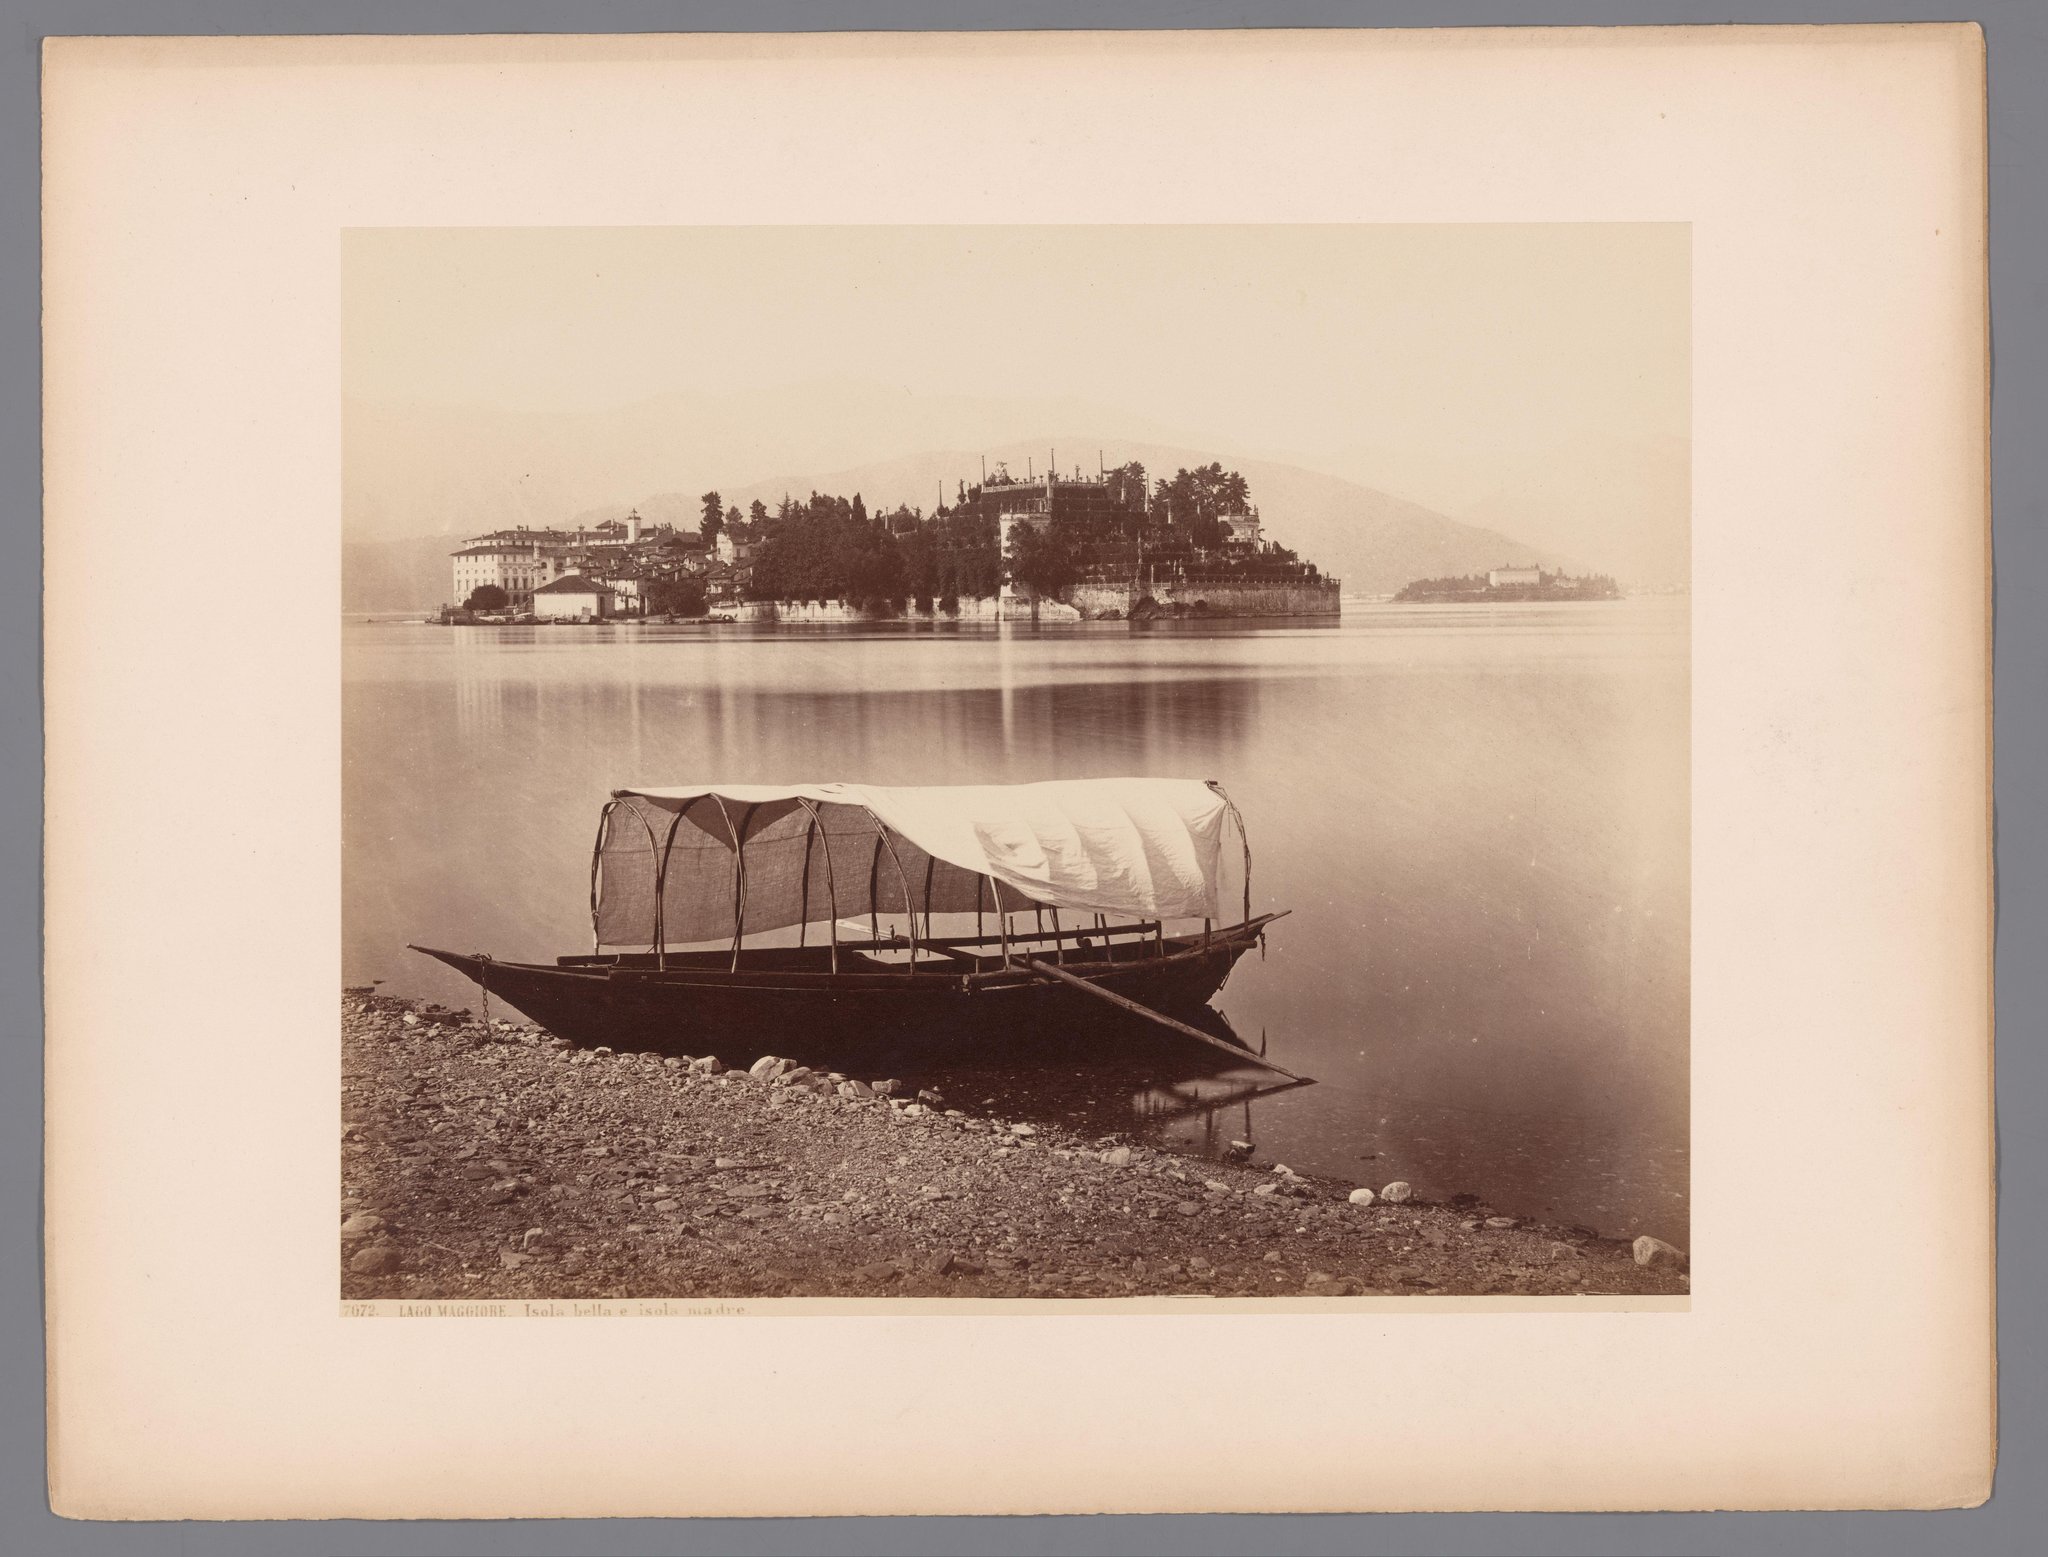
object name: photograph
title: Roeiboot op het Lago Maggiore, op de achtergrond Isola Bella en Isola Madre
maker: Anonymous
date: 1851-1900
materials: cardboard, paper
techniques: albumen print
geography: lake maggiore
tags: island, rowing-boat, canoe, etc., lake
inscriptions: number: ‘7072.’